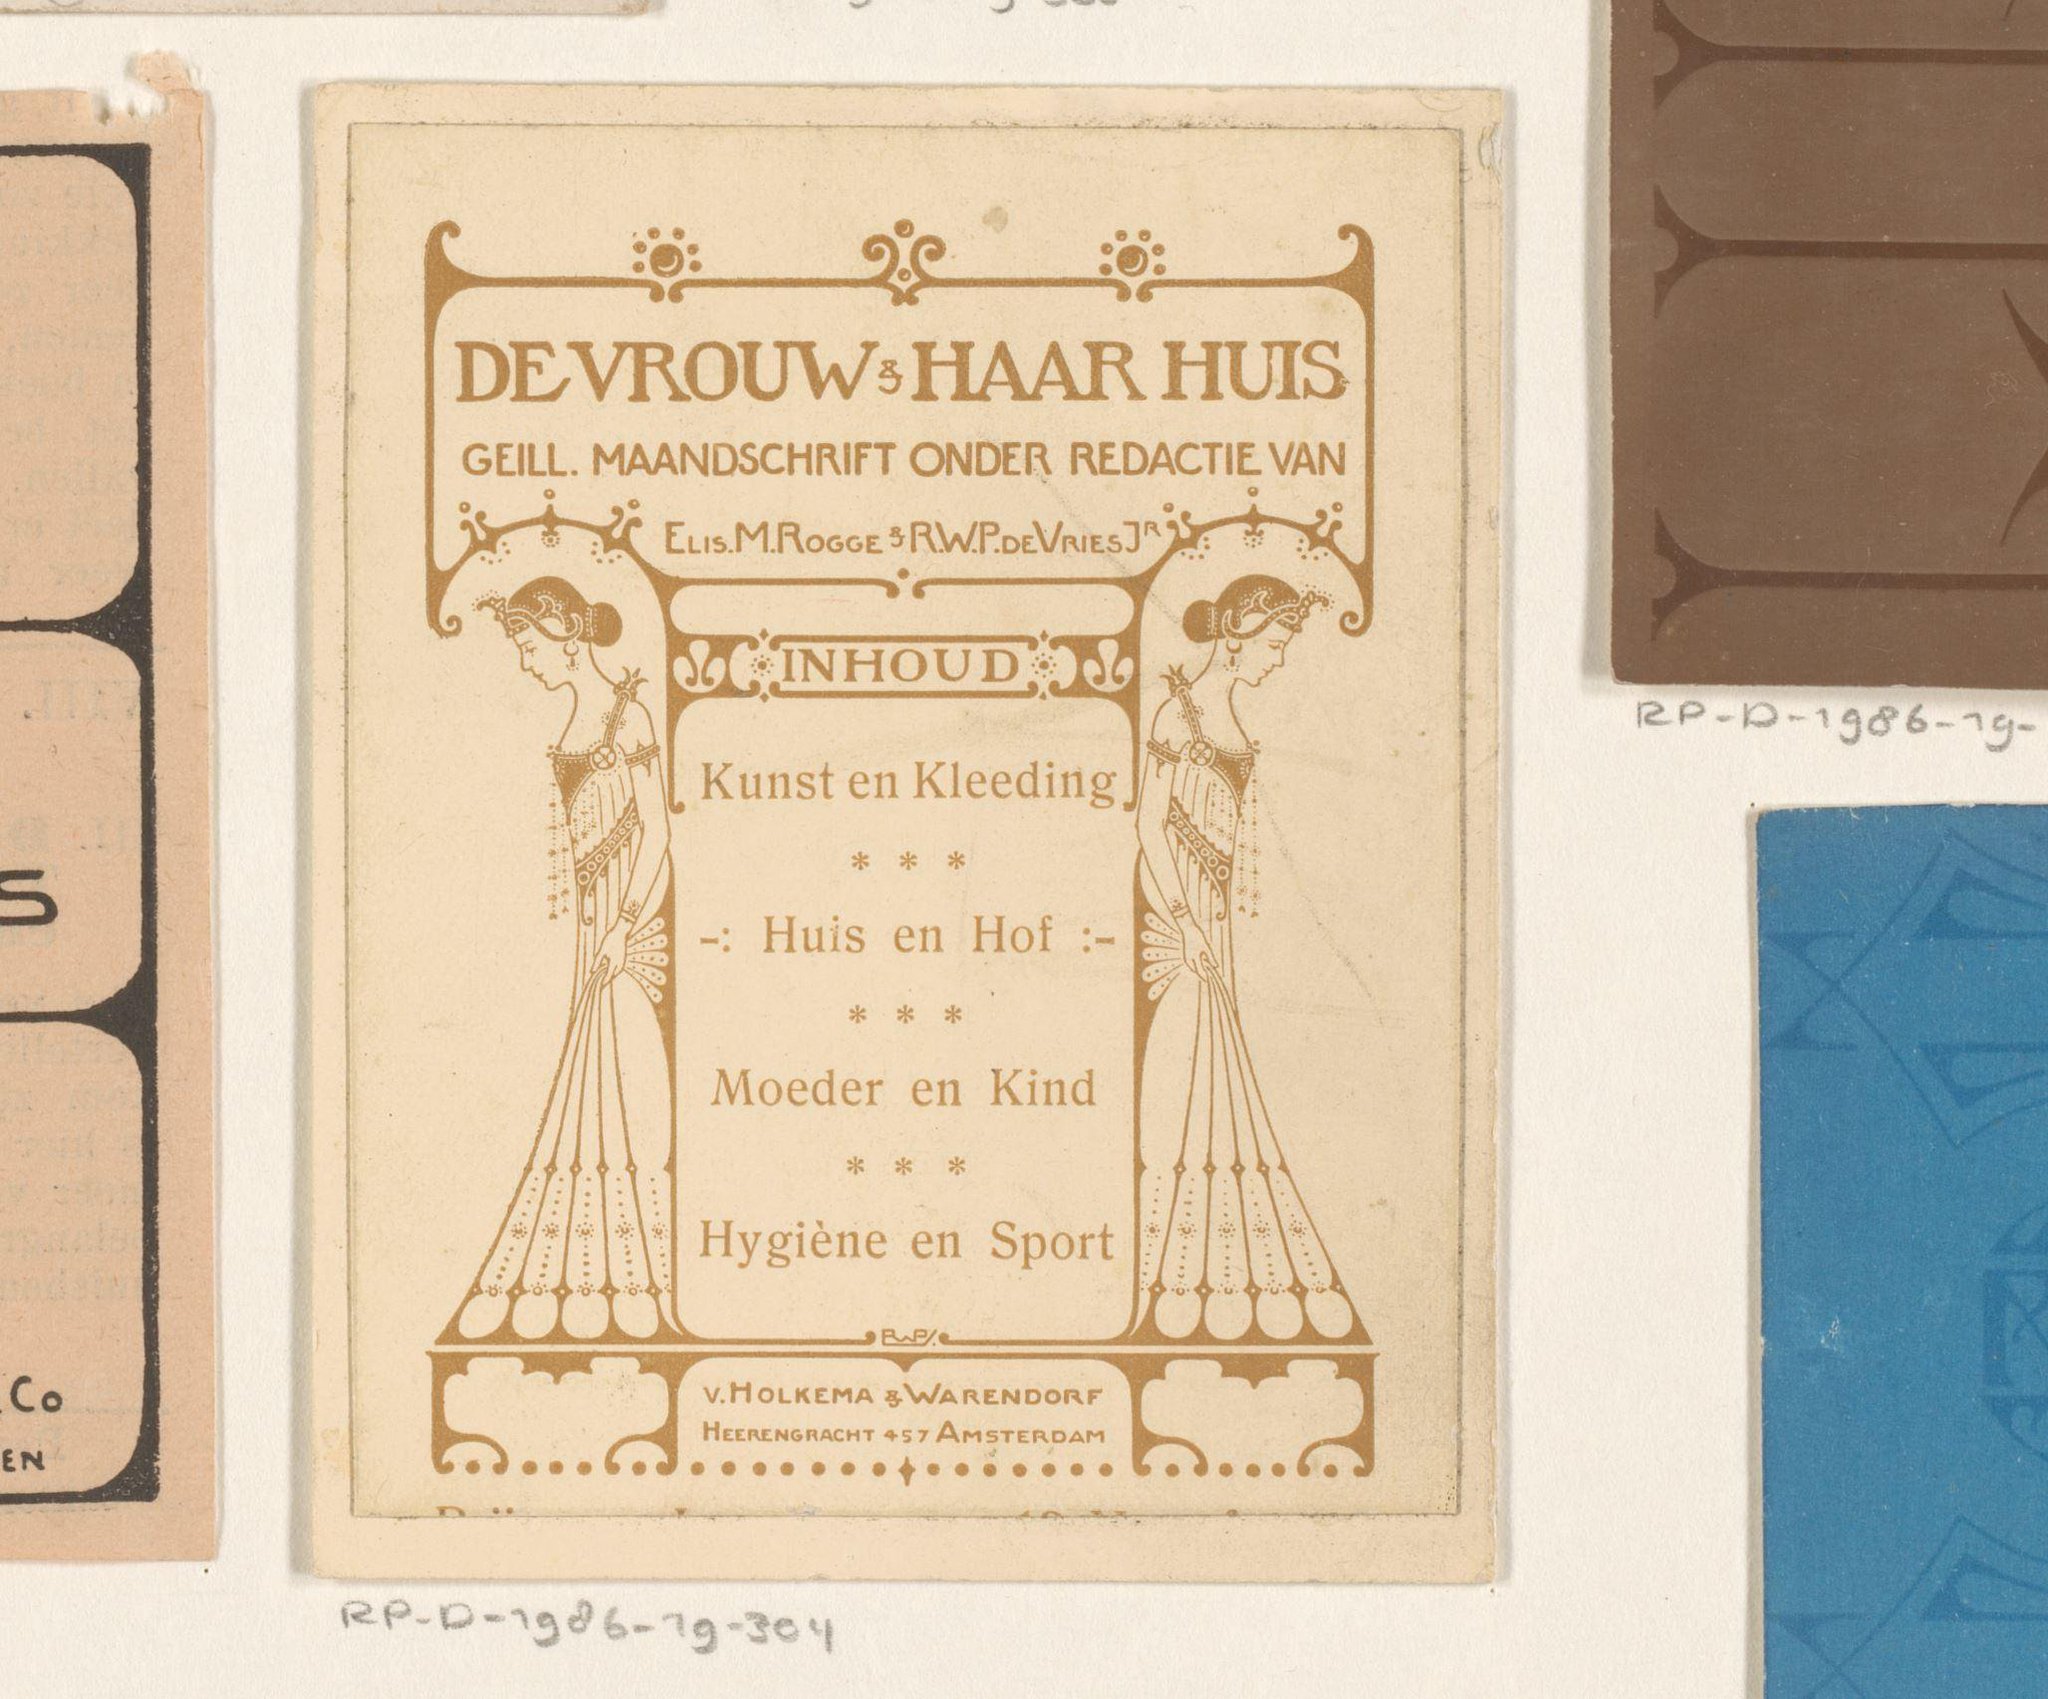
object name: photomechanical print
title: Tekstkader met twee vrouwen in versierde japonnen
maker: reinier willem petrus de vries (1874-1953)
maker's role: draughtsman, print maker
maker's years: 1874-1953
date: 1906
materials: paper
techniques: printing block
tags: dress, gown: evening dress, standing figure - aa - female human figure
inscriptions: collector's mark: ‘R:MVS.’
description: Voorstelling gebruikt als omslag voor: De vrouw en haar huis. Geïllustreerd maandschrift, 1906.